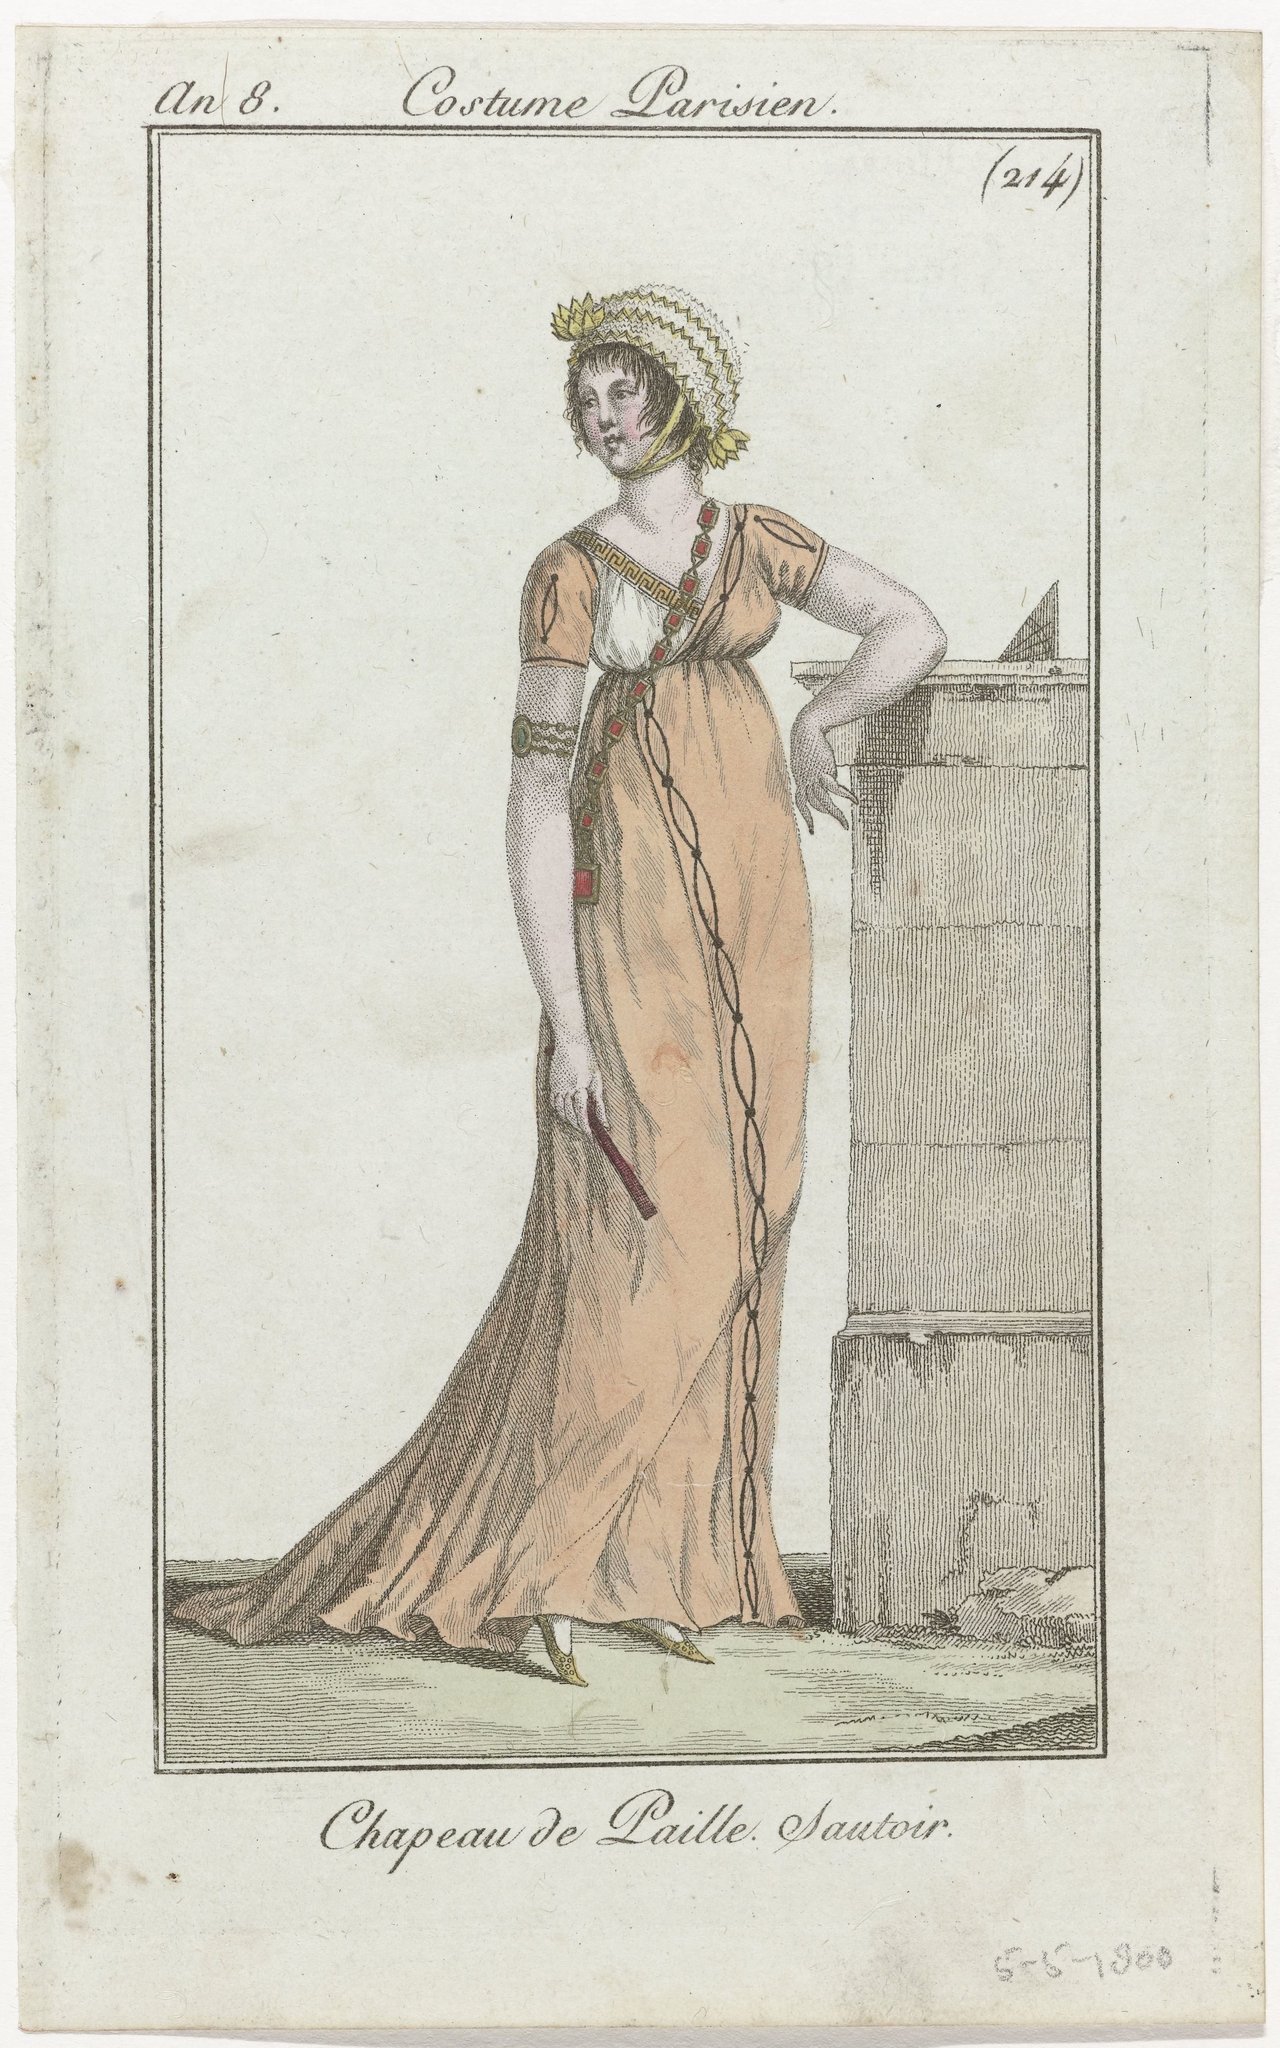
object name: fashion print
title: Journal des Dames et des Modes, Costume Parisien, 5 mai 1800, An 8, (214) : Chapeau de Paill (...)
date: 1800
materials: paper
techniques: engraving, hand coloring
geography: paris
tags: head-gear (+ women's clothes), fashion plates, shoes, sandals (+ women's clothes), dress, gown (+ women's clothes), fan (+ women's clothes), sundial, bracelet, wristlet (+ women's clothes), necklace (+ women's clothes)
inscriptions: title: ‘Costume Parisien.’, caption: ‘Chapeau de Paille. Sautoir.’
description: Staande vrouw met op het hoofd een strohoed met bloemen. Lang collier schuin voor de borst. Zij draagt een japon met overslag, afgezet met een meandermotief en lussenpatroon. Korte mouwen en sleep. Verdere accessoires: armband om de rechter bovenarm, waaier, platte schoenen met puntige neuzen. Met de linkerarm leunt zij op een sokkel met zonnewijzer. De prent maakt deel uit van het modetijdschrift Journal des Dames et des Modes, uitgegeven door Pierre de la Mésangère, Parijs, 1797-1839.